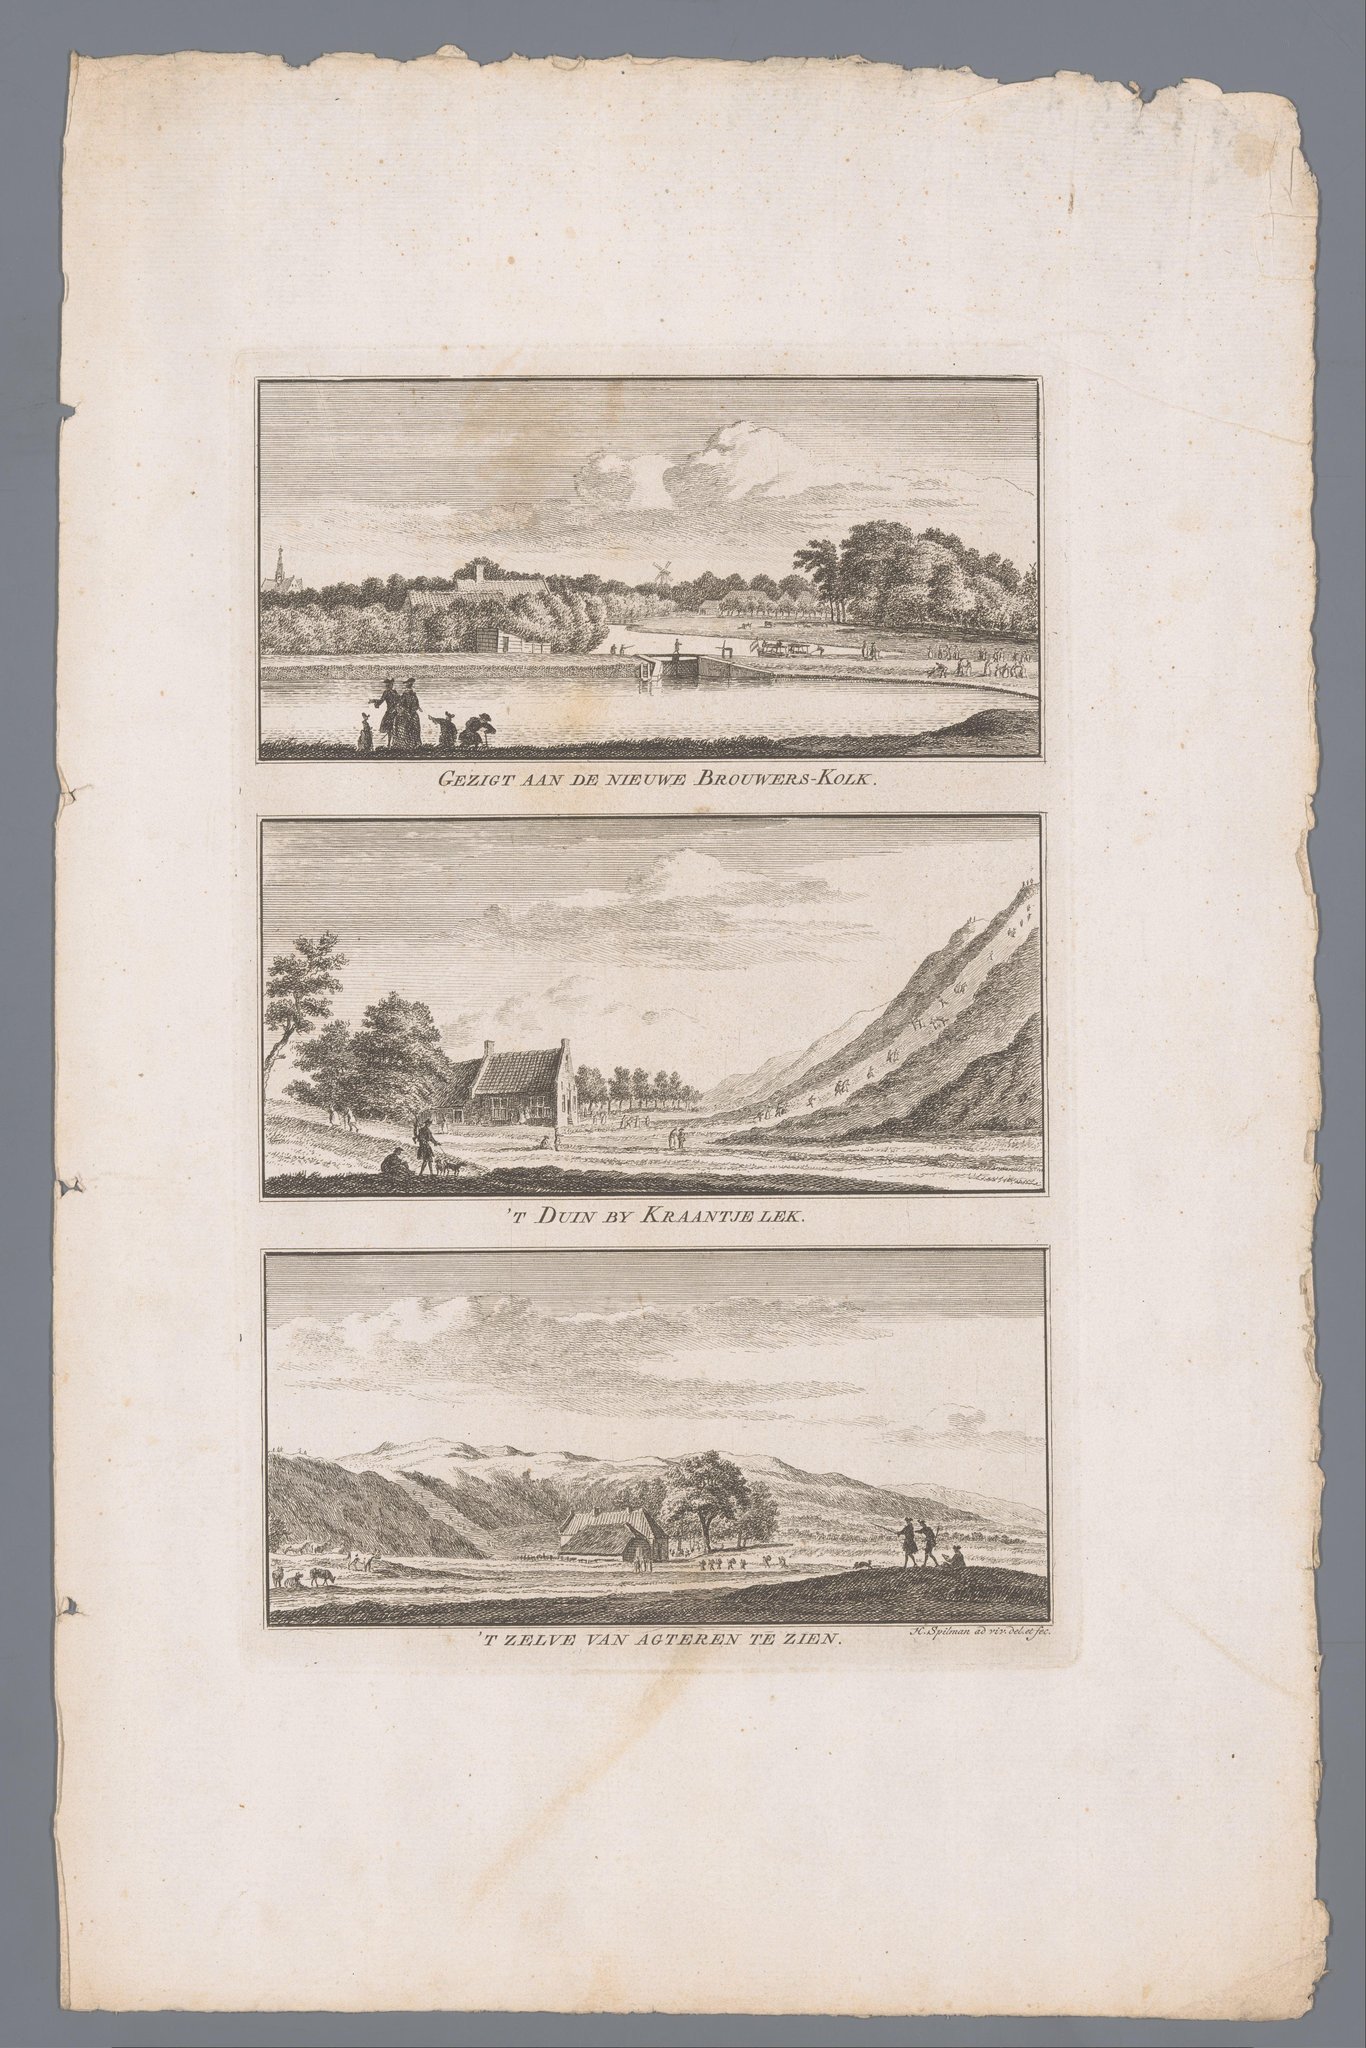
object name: print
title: Gezigt aan de Nieuwe Brouwers-Kolk / 'T Duin by Kraantje Lek / 'T zelve van agteren te zien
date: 1763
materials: paper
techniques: etching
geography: haarlem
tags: landscapes in the temperate zone, dunes (sea not visible); in the dunes, open-air recreation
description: Drie voorstellingen. Boven: Gezicht op de Nieuwe Brouwerskolk. Midden: Gezicht op de uitspanning Kraantje Lek en het duin De Blinkert. Onder: Gezicht op de achterzijde van de uitspanning Kraantje Lek te Overveen.